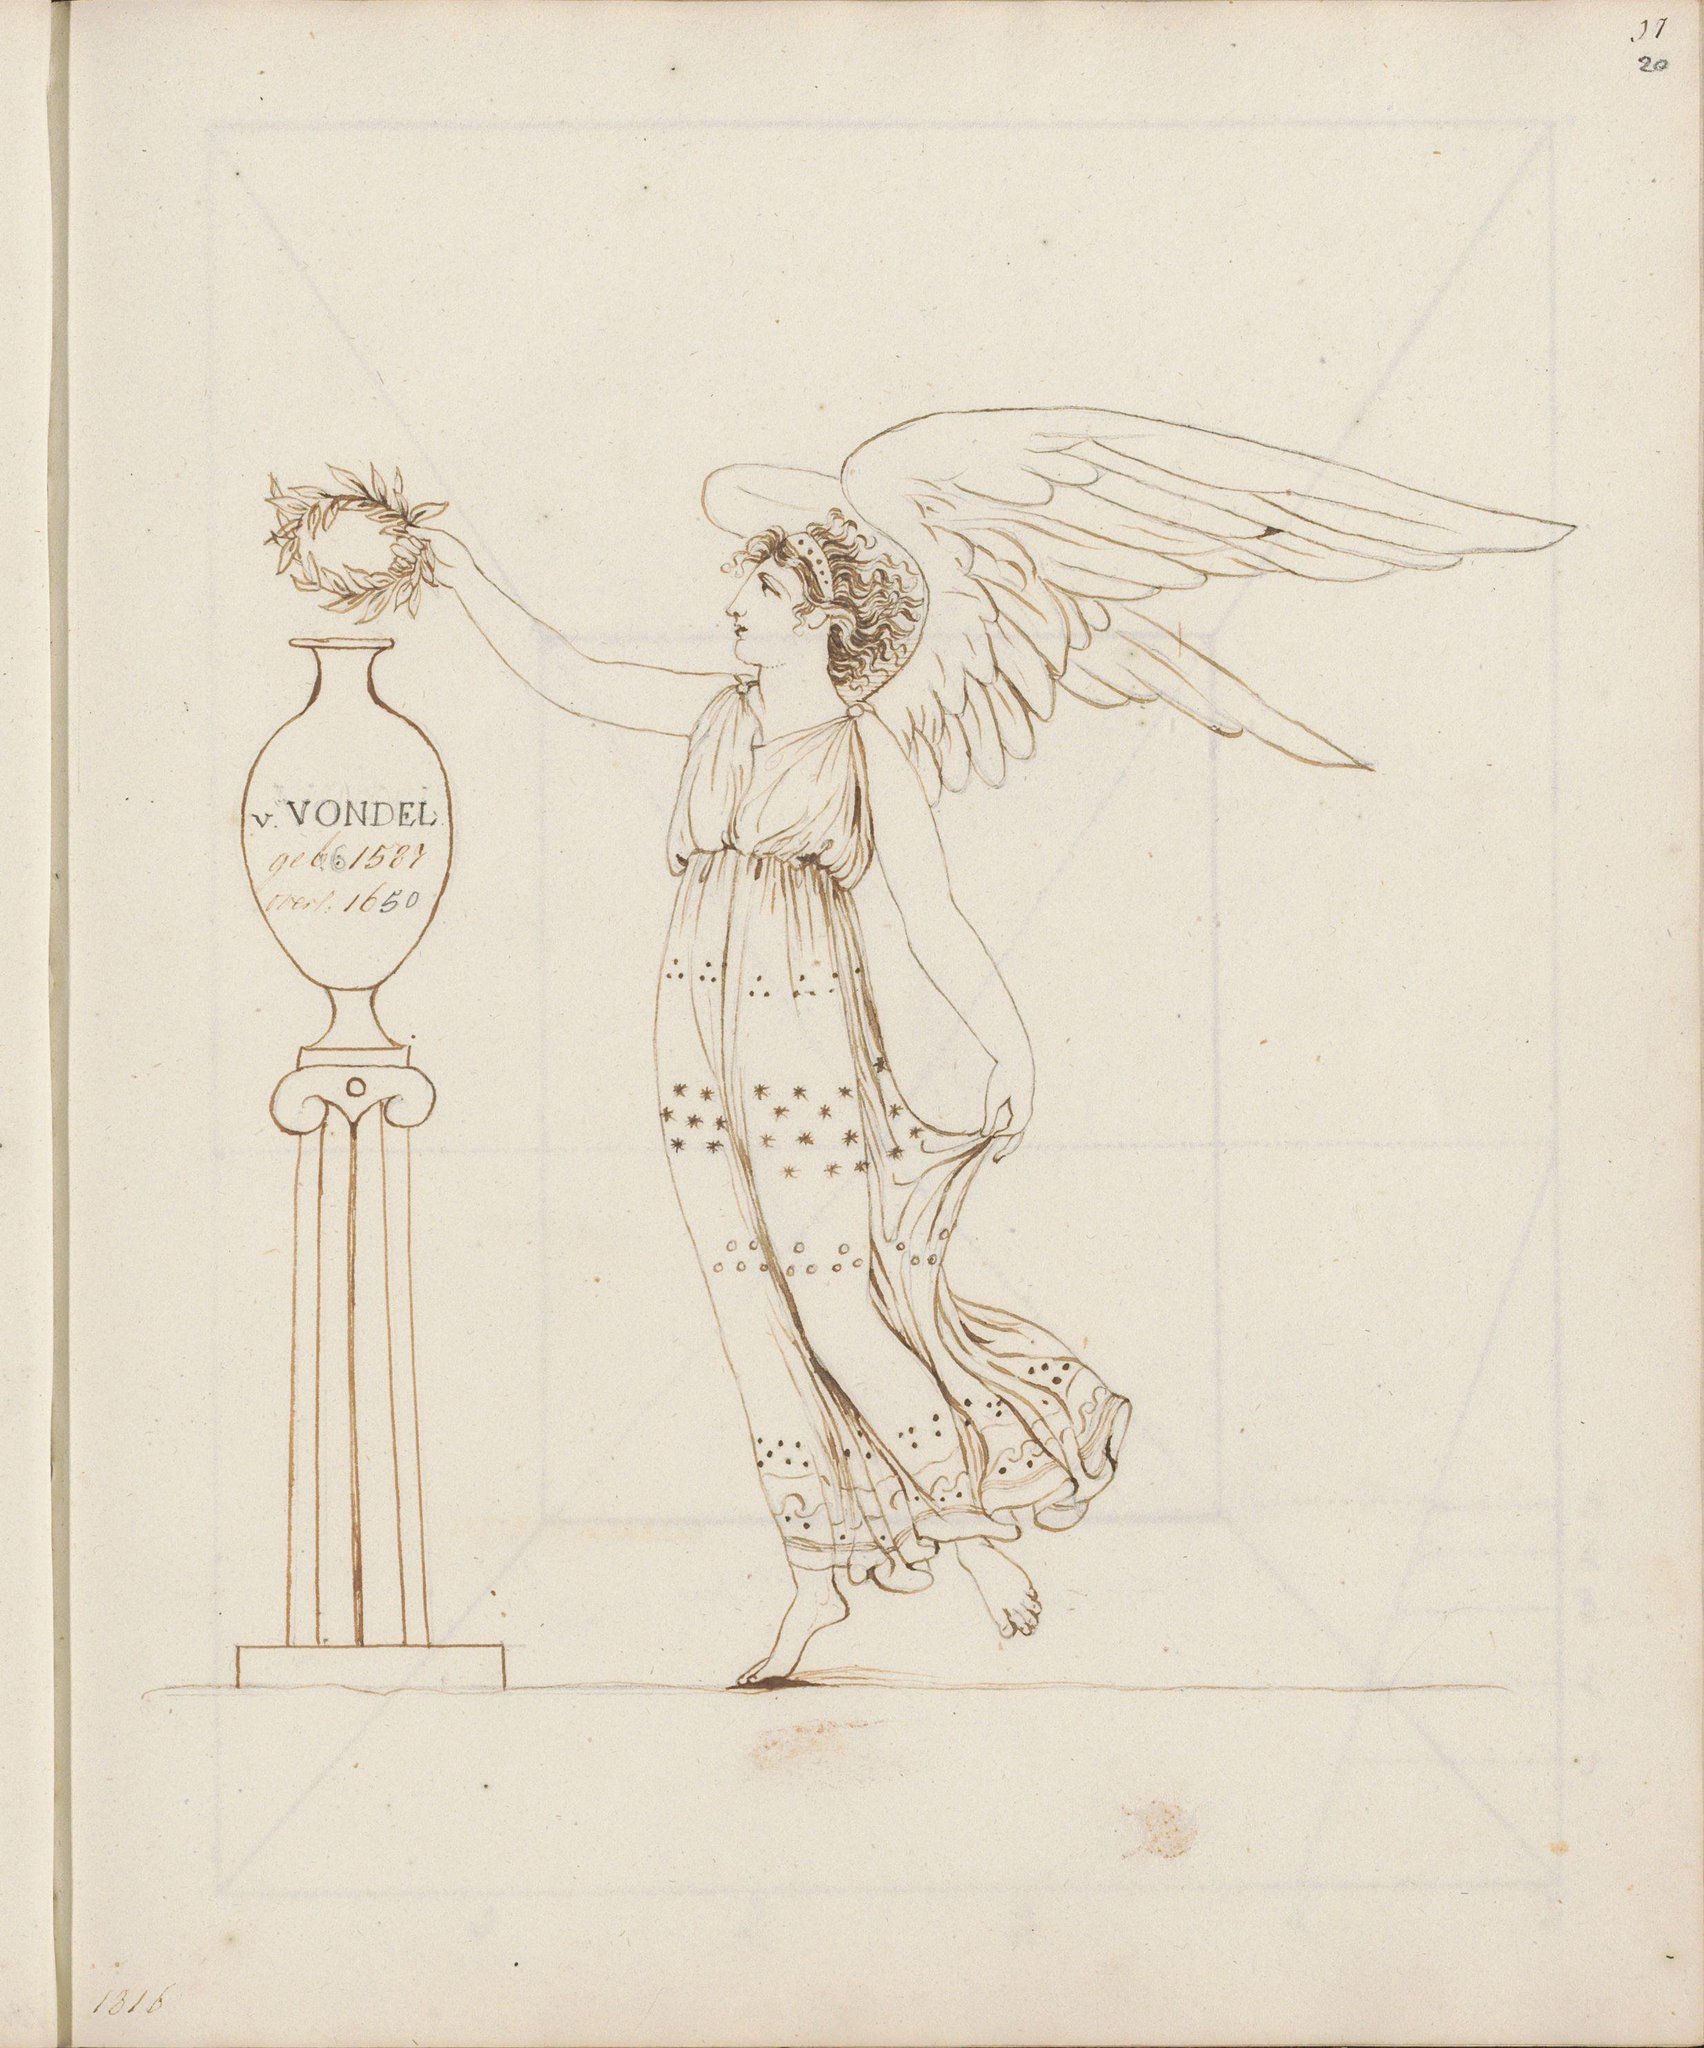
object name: sketchbook leaf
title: Fama die een olijfkrans plaatst op een monument voor Joost van den Vondel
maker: jonkvrouw elisabeth kemper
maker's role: draughtsman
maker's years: 1799-1871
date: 1816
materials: ink, paper, pencil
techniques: pen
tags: cologne, amsterdam, joost van den vondel, monument, statue, fame; 'fama', 'fama buona', 'fama chiara' (ripa), angels, trees: olive-tree (+ branch, stick)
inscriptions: annotation: ‘v. VONDEL/ geb. 1587/ overl. 1650’, date: ‘1816’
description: Blad 20 recto uit een schetsboek met 94 bladen.